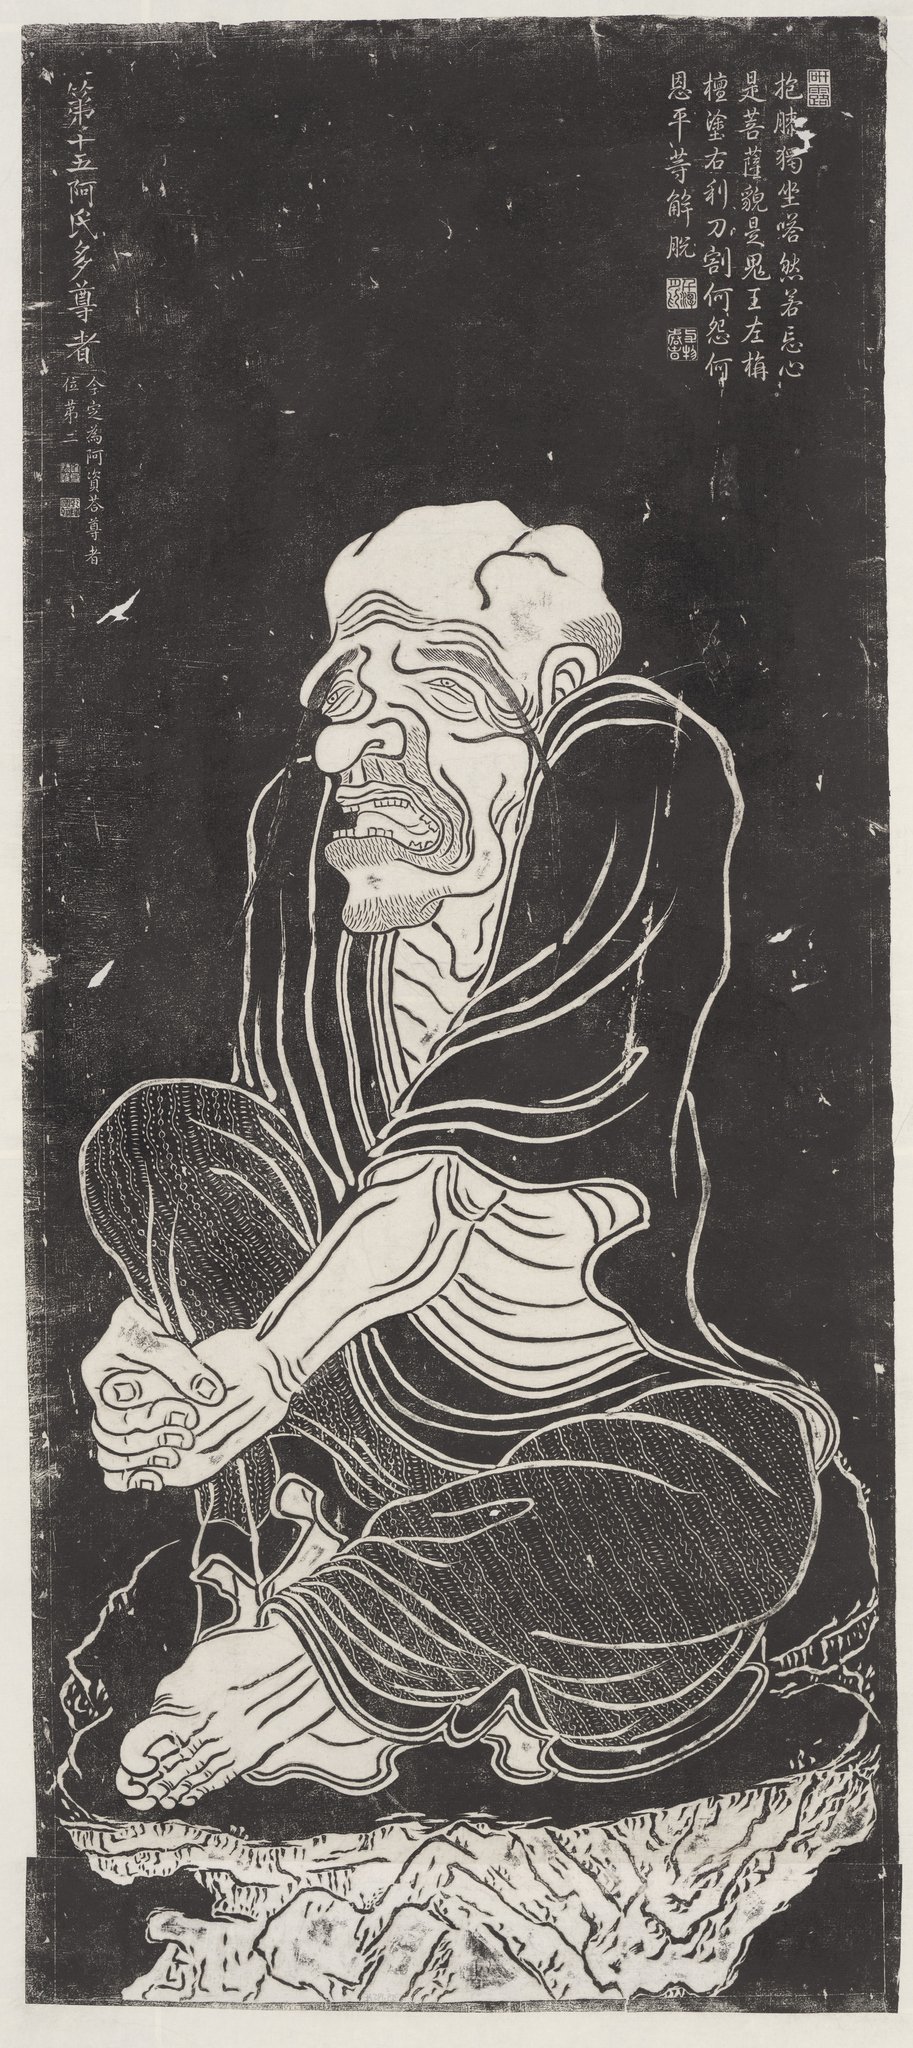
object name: rubbing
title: Luohan, after a set attributed to Guanxiu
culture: chinese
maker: unidentified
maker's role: artist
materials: ink, paper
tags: men